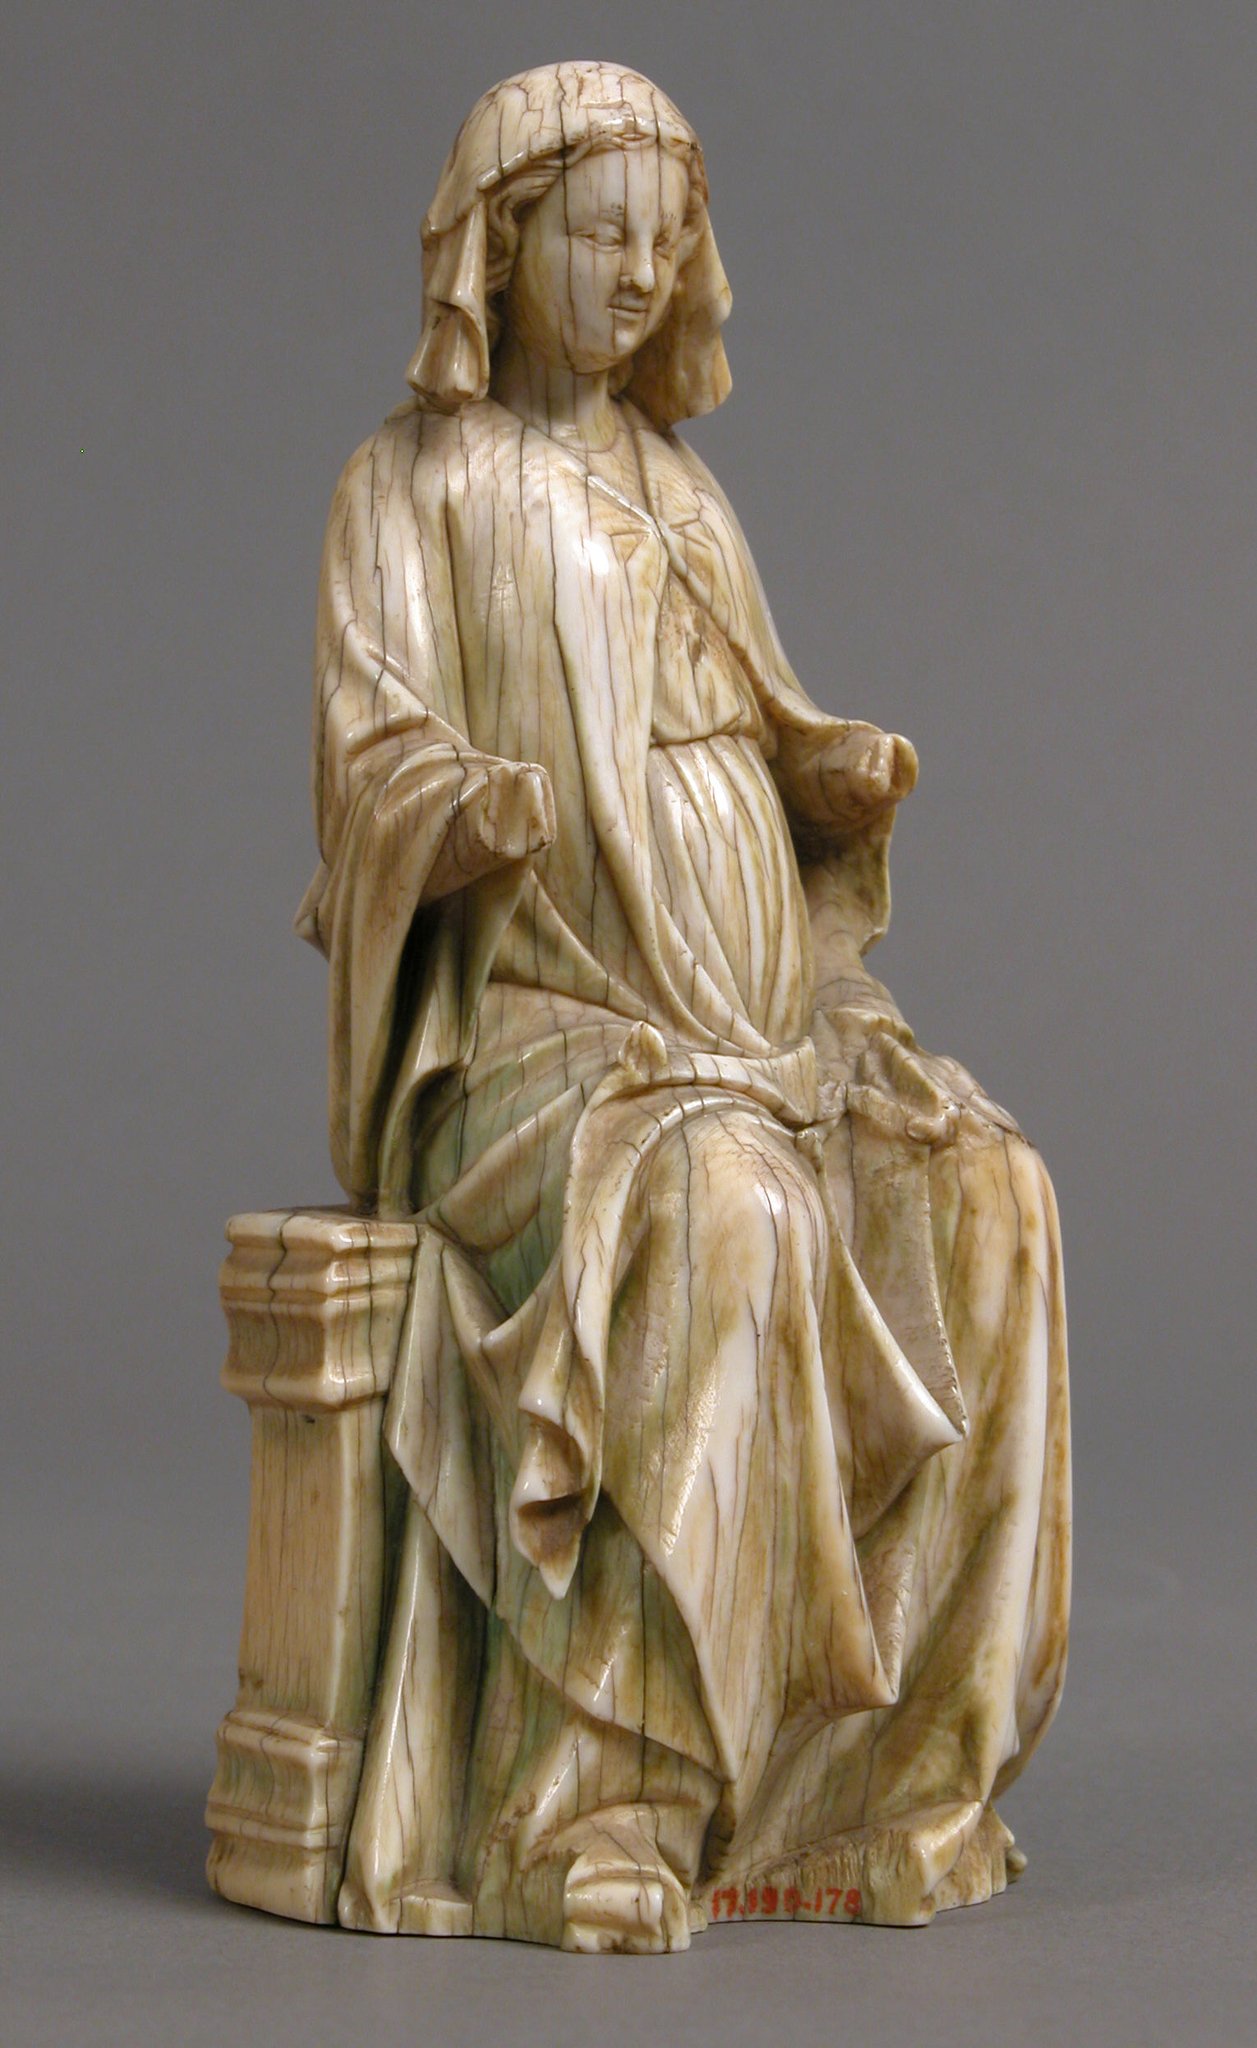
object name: statuette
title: Virgin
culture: french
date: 1300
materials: ivory